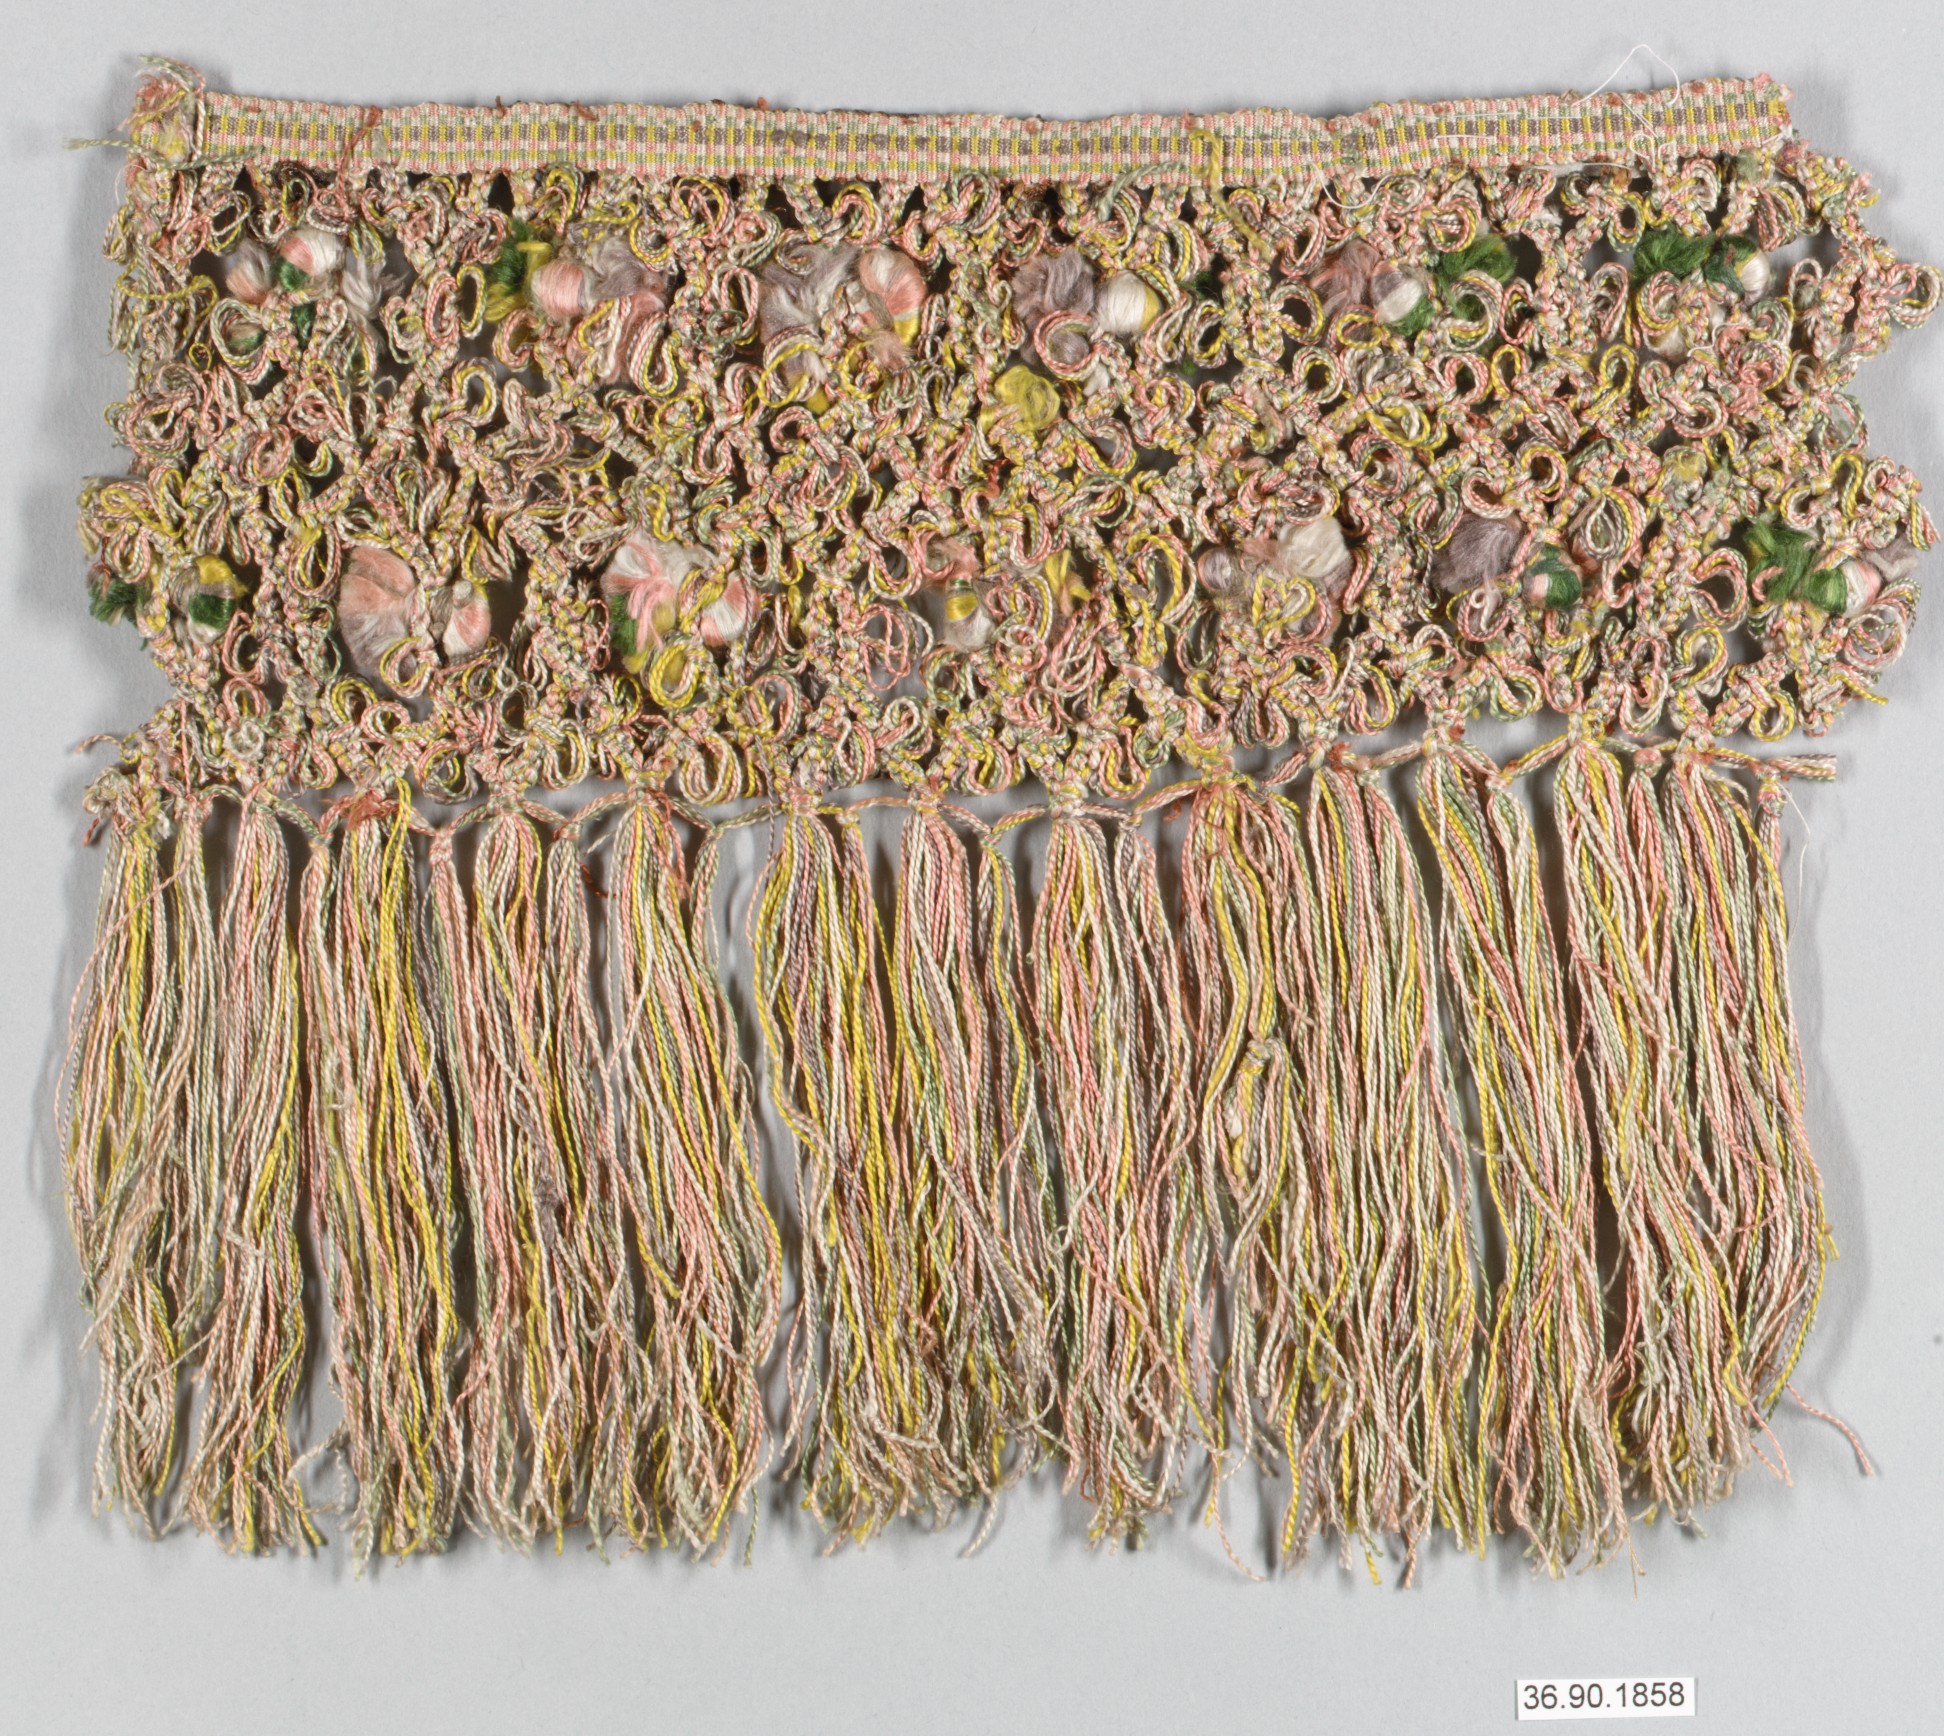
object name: fringe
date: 1850